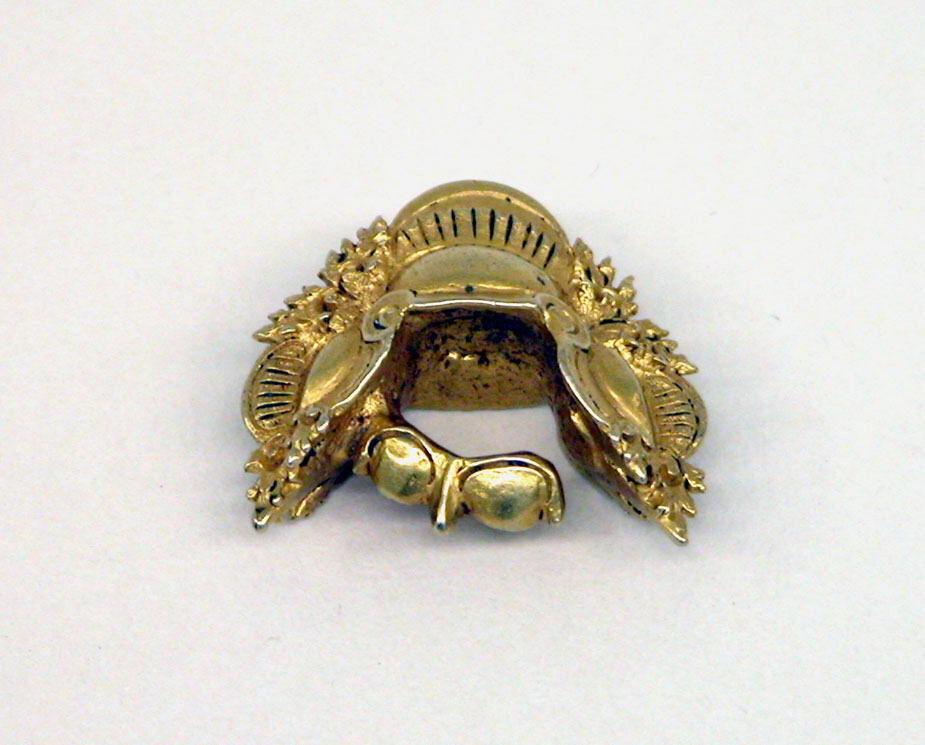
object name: ear ornament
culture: indonesian, javanese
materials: gold